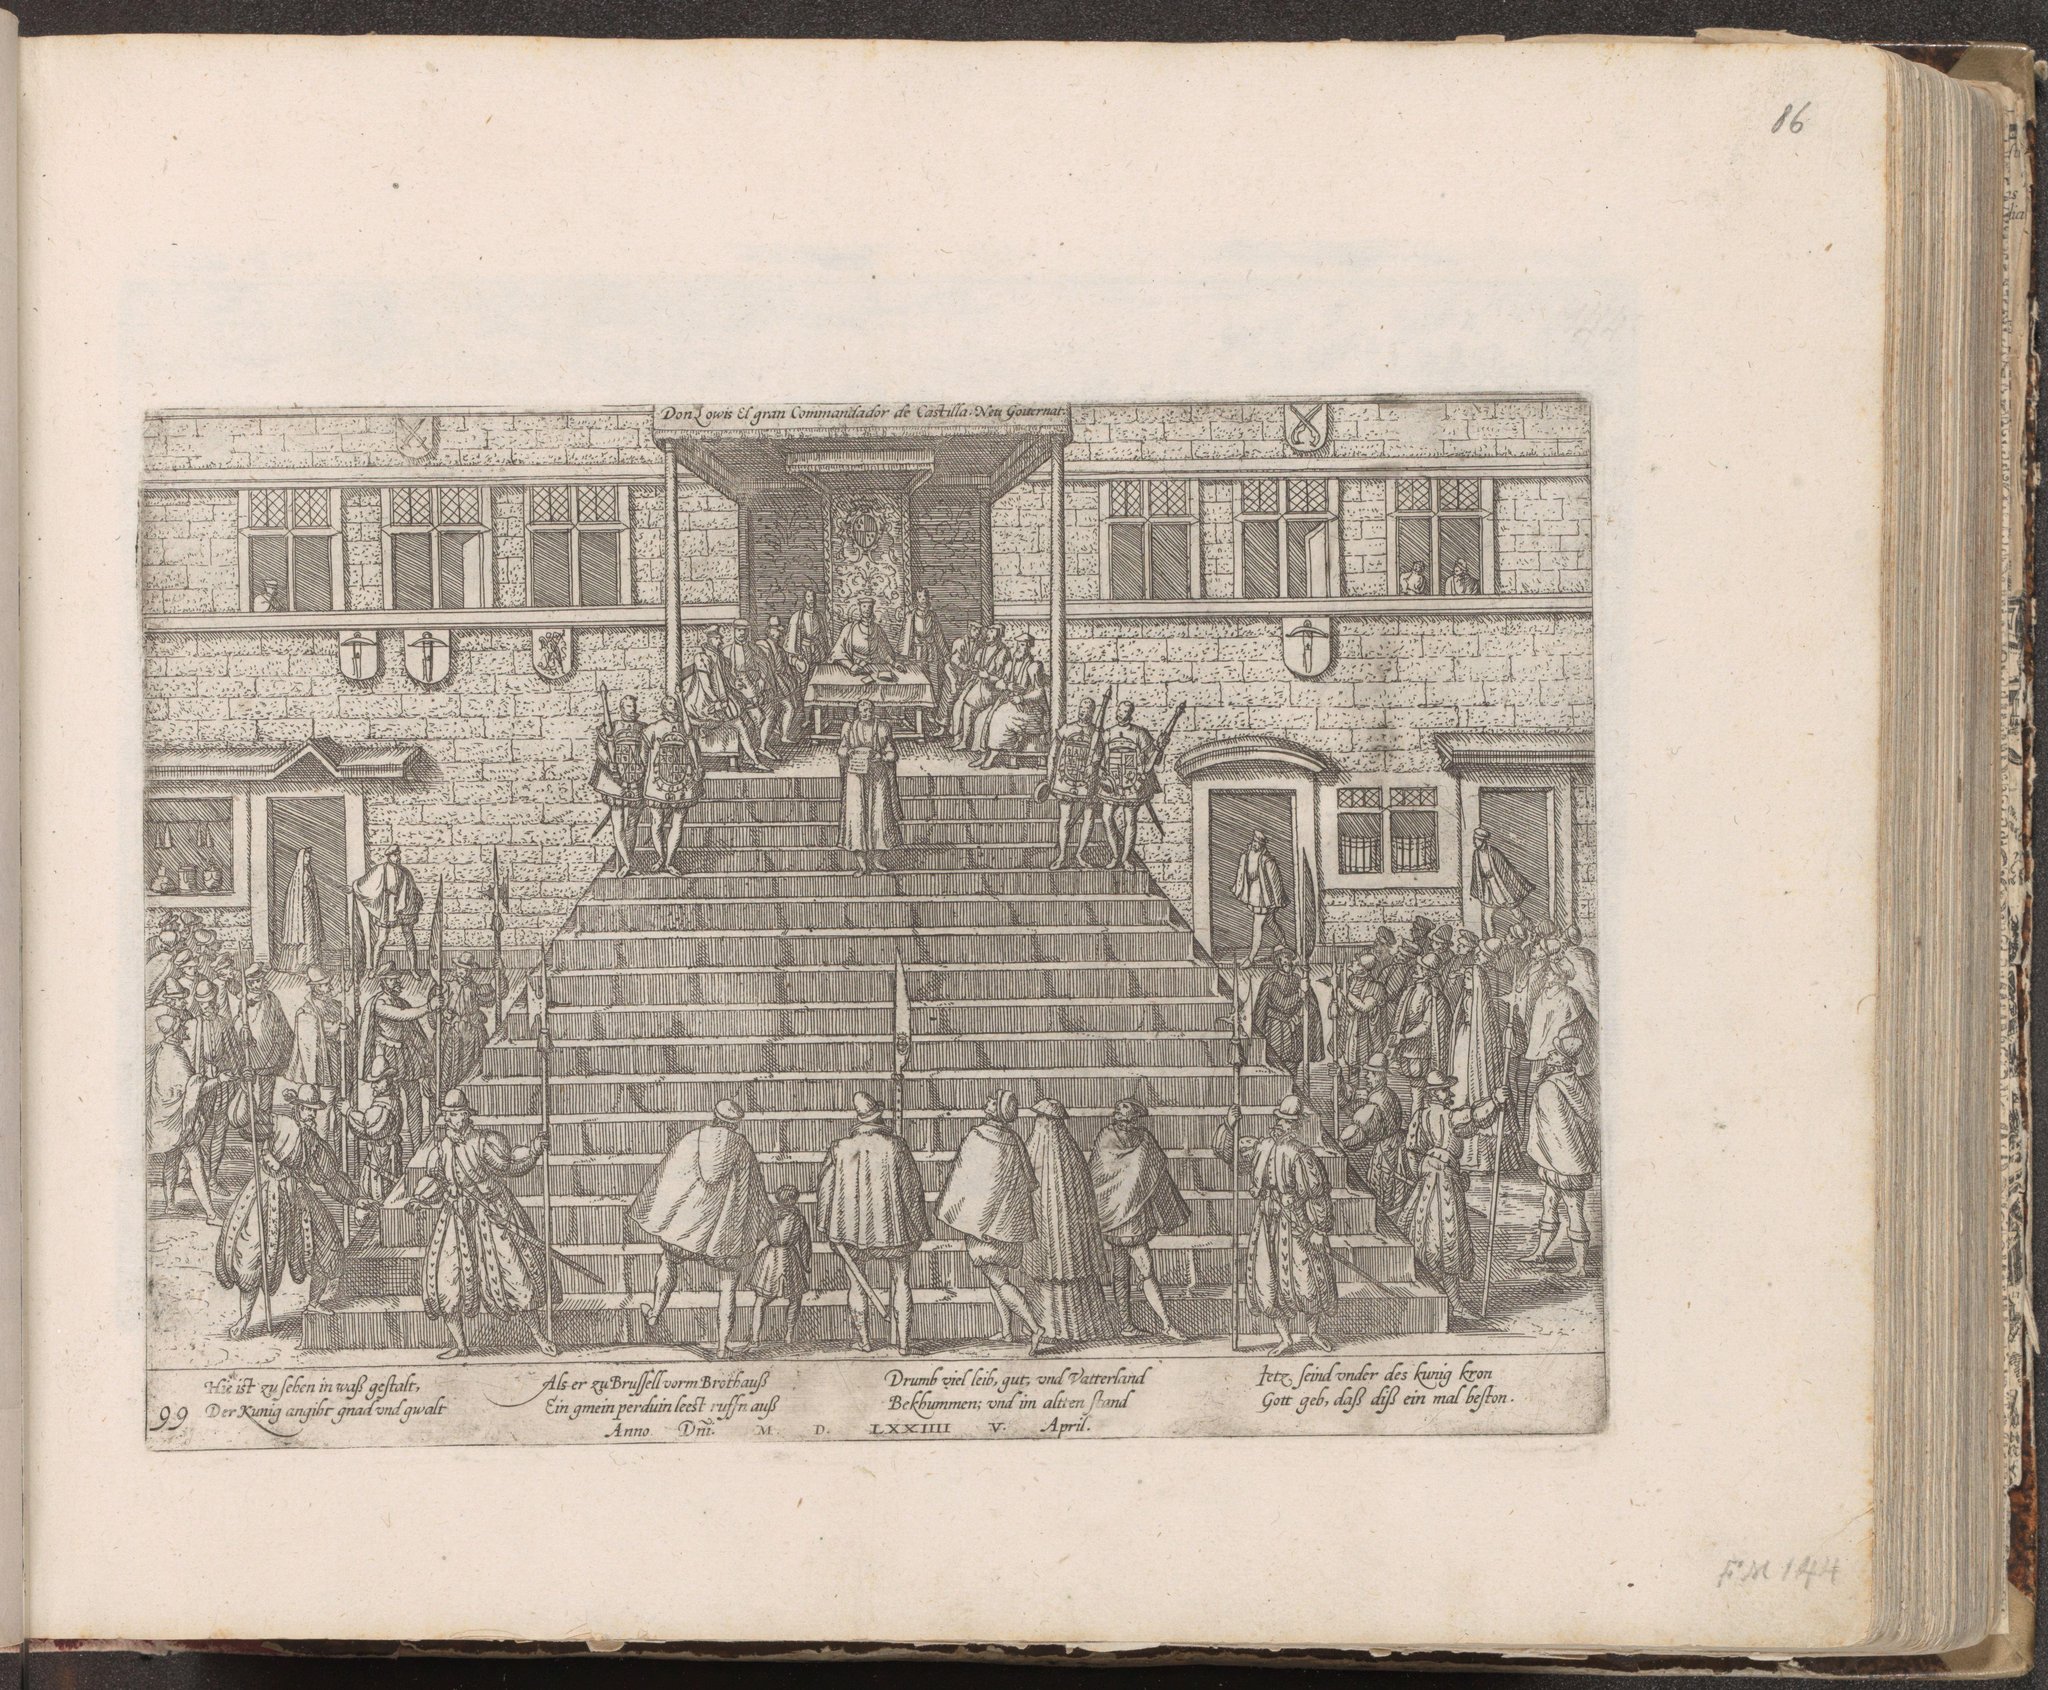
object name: album leaf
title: Afkondiging van het tweede Generaal Pardon, 1574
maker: frans hogenberg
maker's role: print maker, publisher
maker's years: 1538-1590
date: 1574-1578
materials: paper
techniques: etching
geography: cologne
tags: brussels, mayor, luis de zúñiga y requesens, granting mercy; free pardon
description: Afkondiging van het tweede Generaal Pardon, 5 april 1574. Voor het Broodhuis te Brussel laat Requesens het Generaal Pardon voorlezen. Met onderschrift van 8 regels in het Duits. Linksonder genummerd: 99. De prent maakt deel uit van een album.